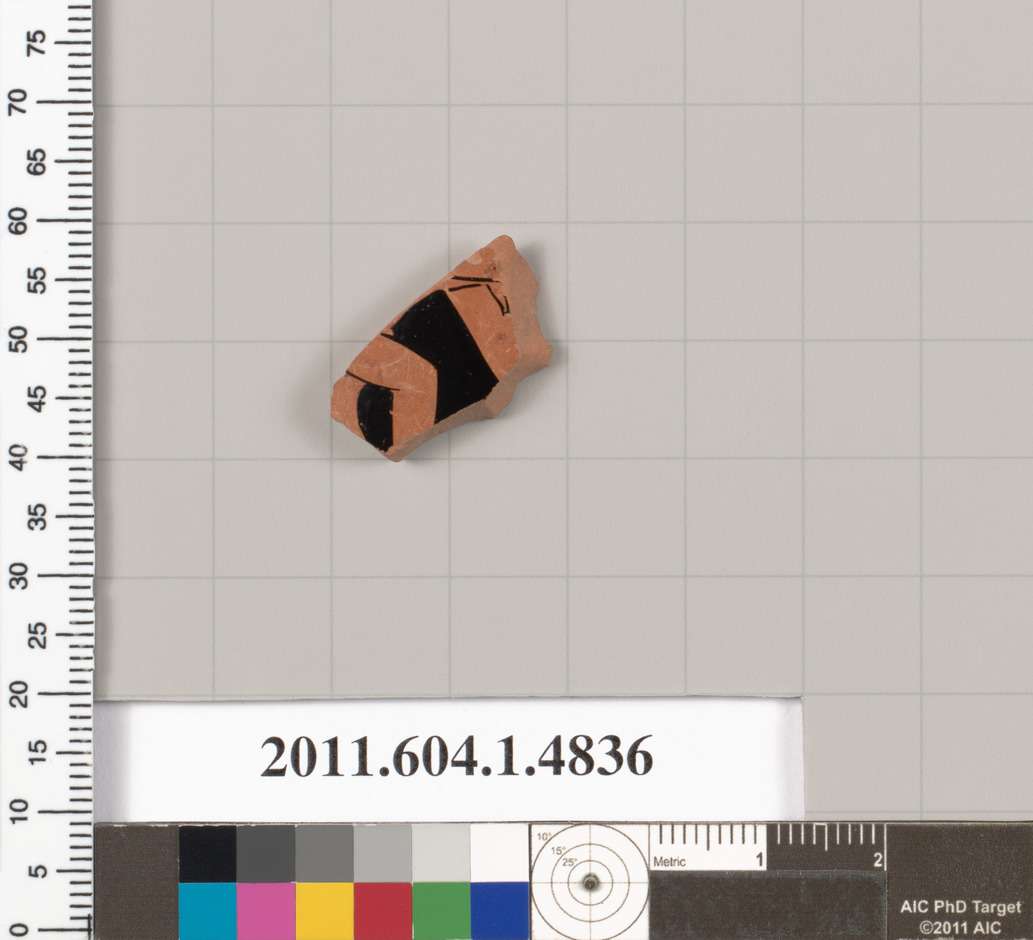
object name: kylix fragment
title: Terracotta fragment of a kylix (drinking cup)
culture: greek, attic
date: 500-480 BCE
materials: terracotta